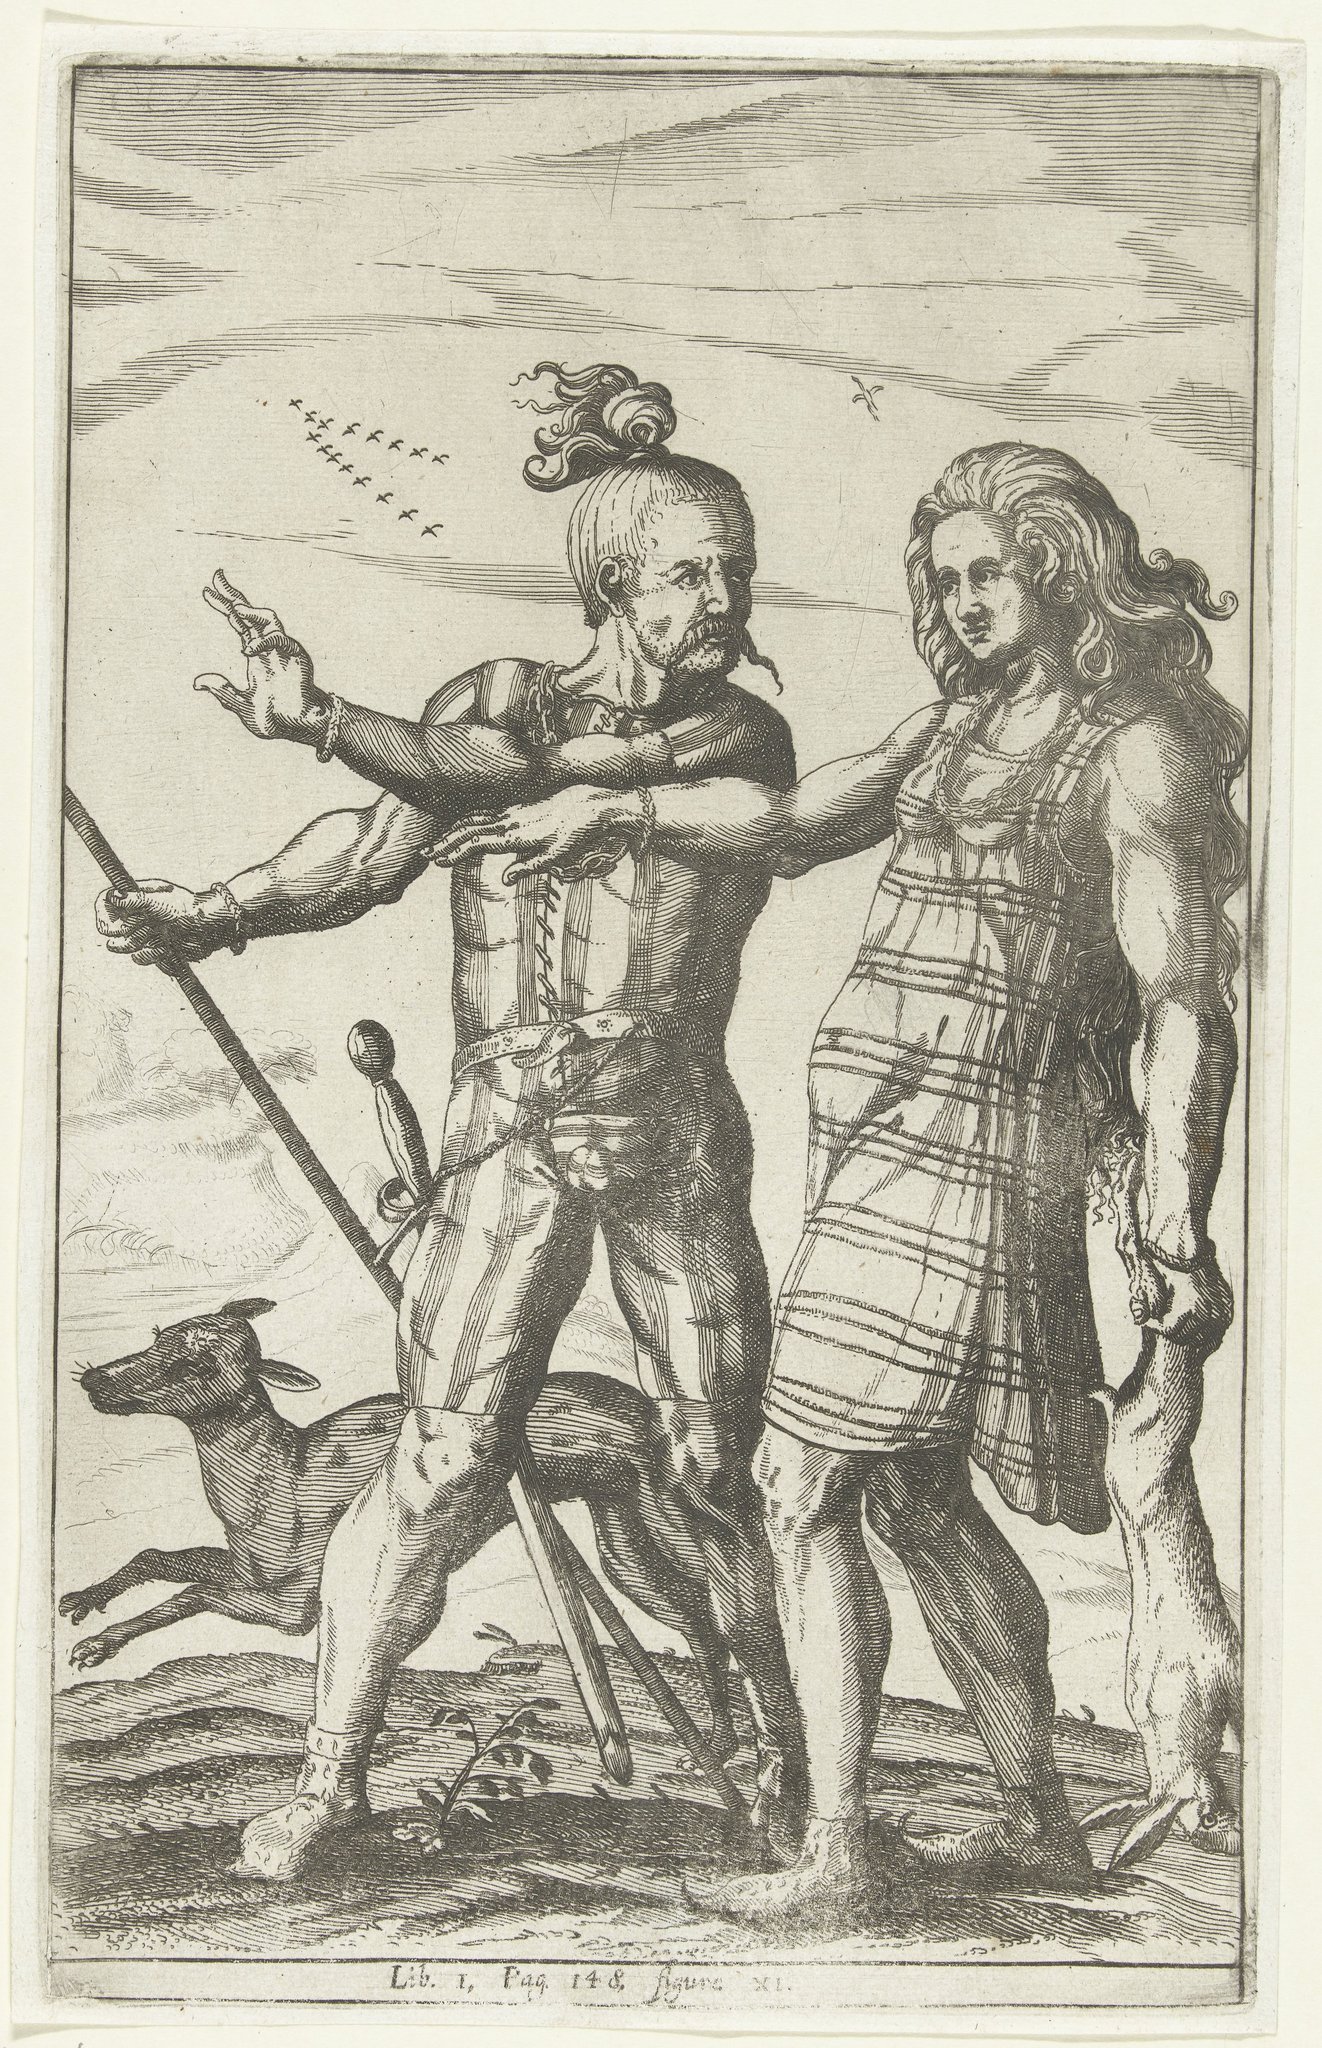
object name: history print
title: Germaanse man en vrouw op jacht, figura XI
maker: nicolaes van geelkercken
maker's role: print maker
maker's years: 1585-1656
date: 1614-1616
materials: paper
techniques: etching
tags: extinct, 'historical' peoples (with name)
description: Germaanse man en vrouw op jacht. Afkomstig uit: Philippus Cluverius, Germaniæ antiquæ libri tres, Lowijs (I) Elzevier, Leiden, 1616. Lib. I, Pag. 148, figura XI